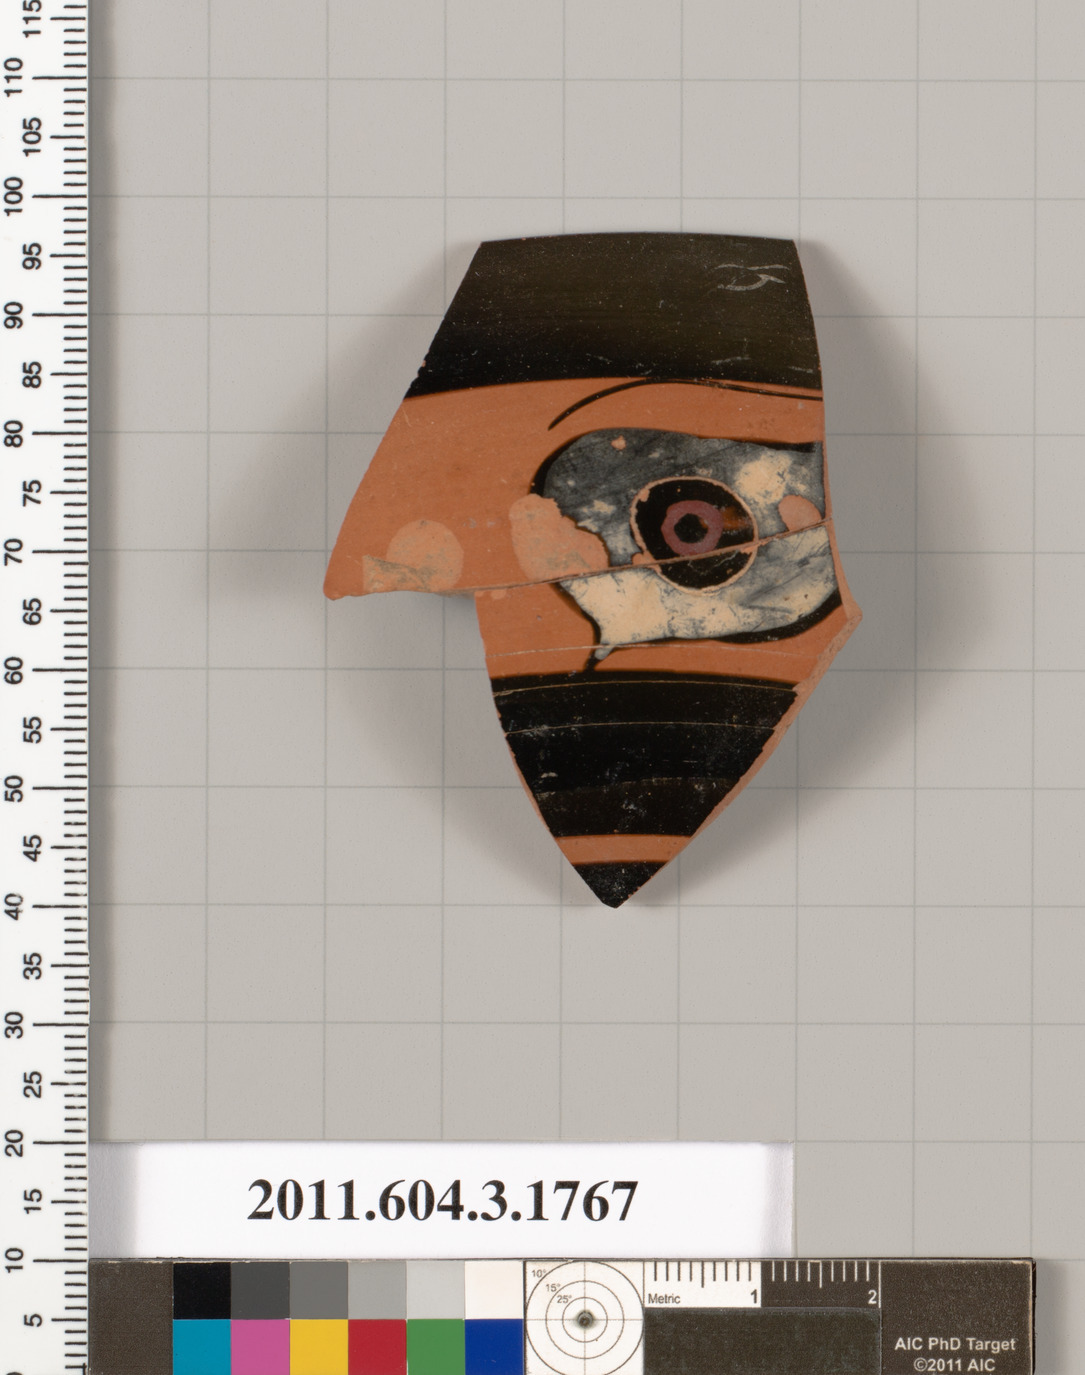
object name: kylix fragment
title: Terracotta rim fragment of a kylix: Band cup (drinking cup)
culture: greek, attic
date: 520-510 BCE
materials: terracotta